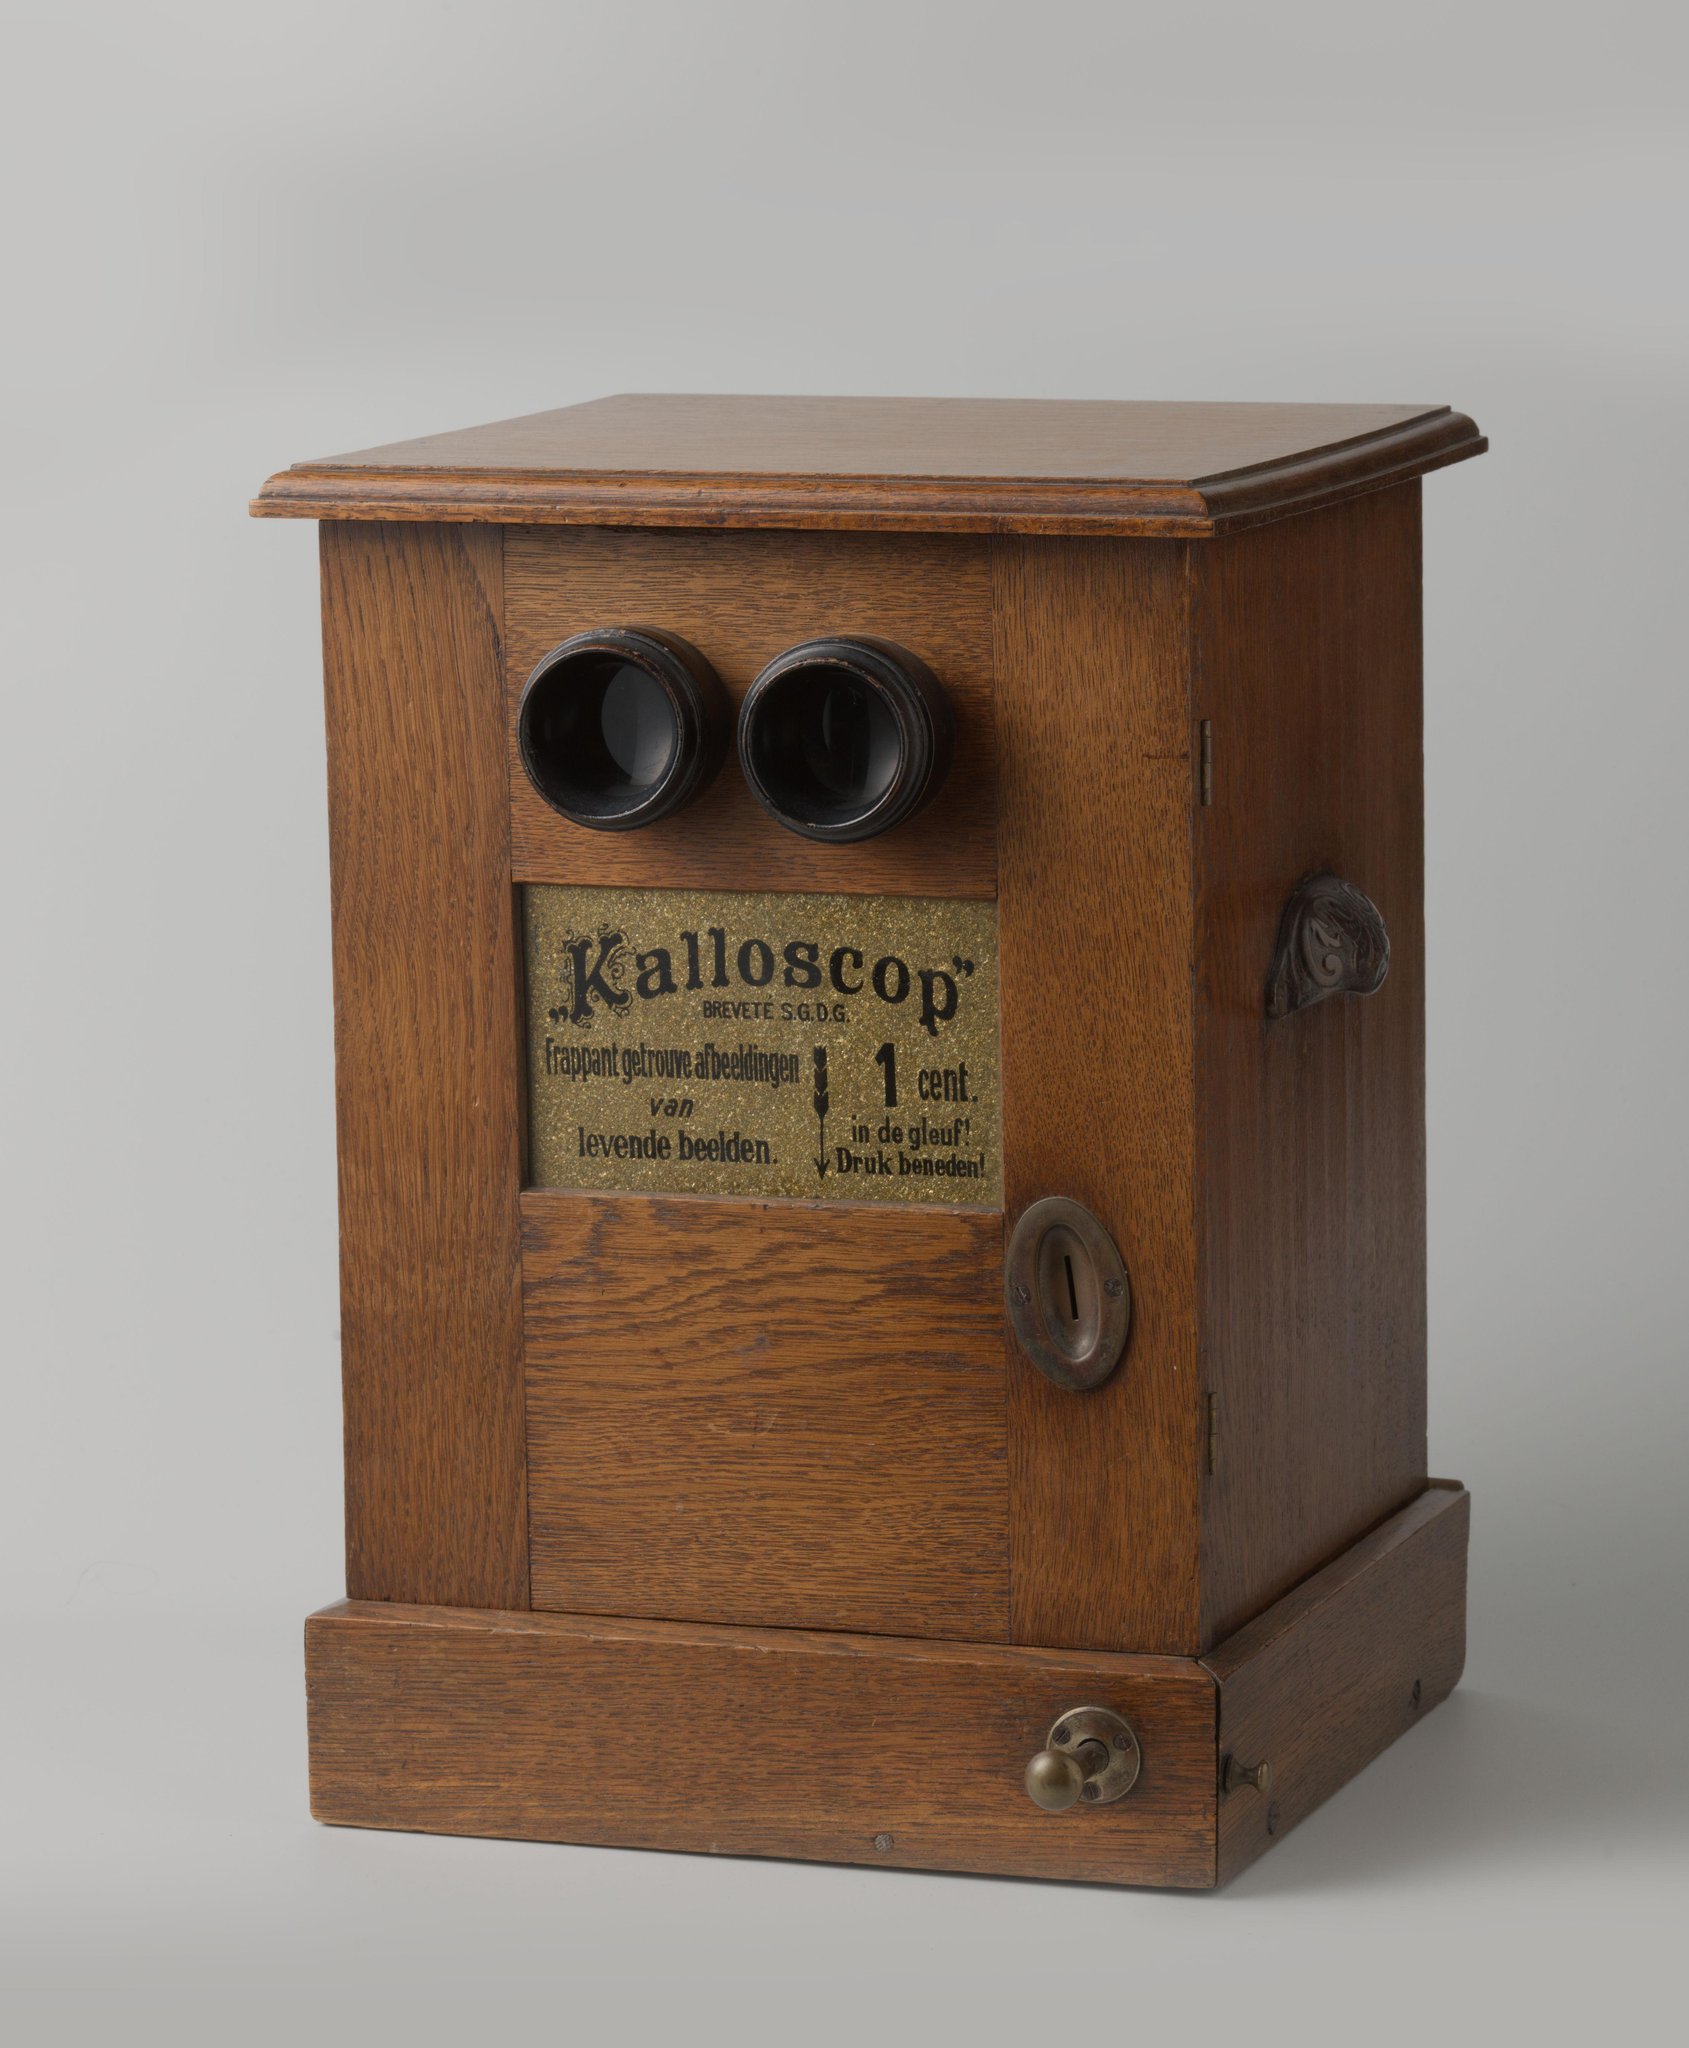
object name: stereoscope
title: Stereoscoop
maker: Anonymous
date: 1860-1920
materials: wood